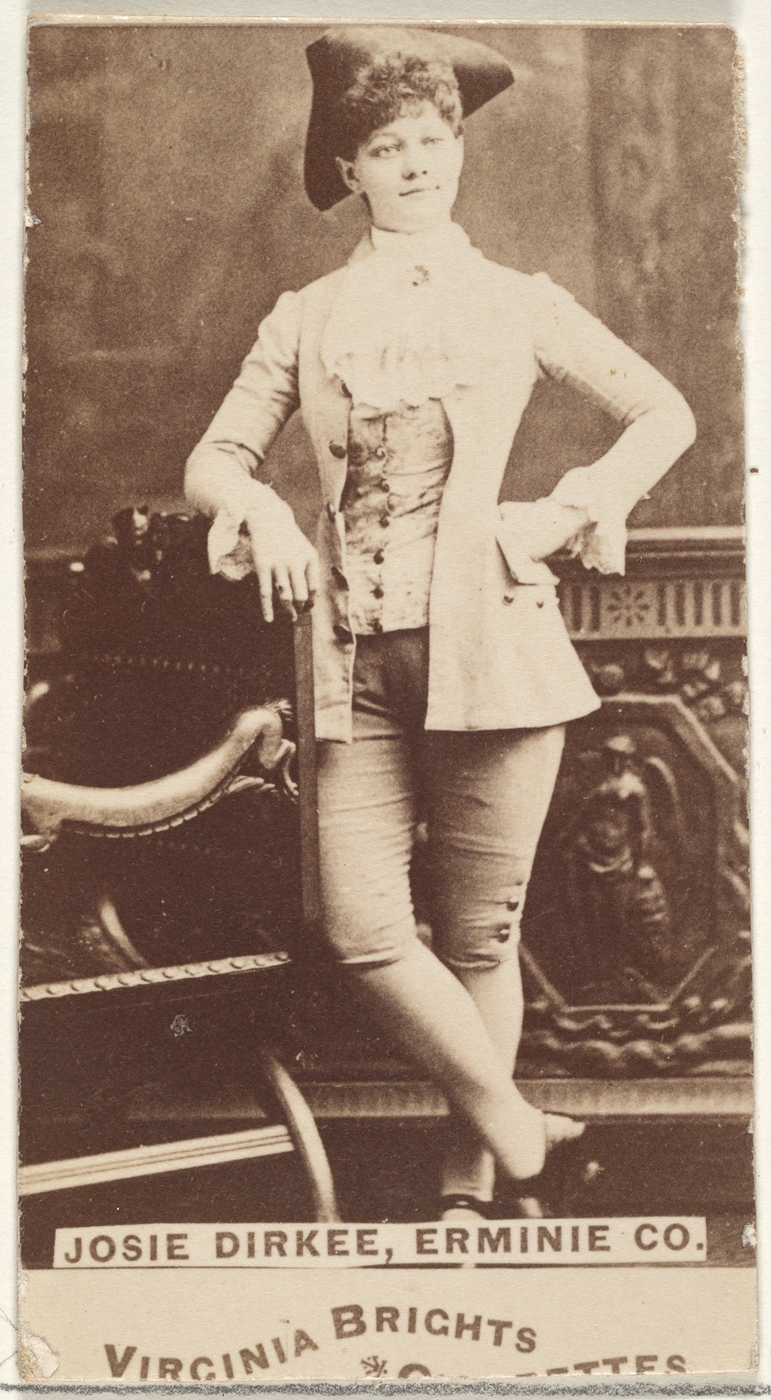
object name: photograph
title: Josie Dirkee, Erminie Co., from the Actors and Actresses series (N45, Type 1) for Virginia Brights Cigarettes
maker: allen & ginter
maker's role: publisher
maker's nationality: american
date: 1888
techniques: albumen silver print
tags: portraits,women,actresses